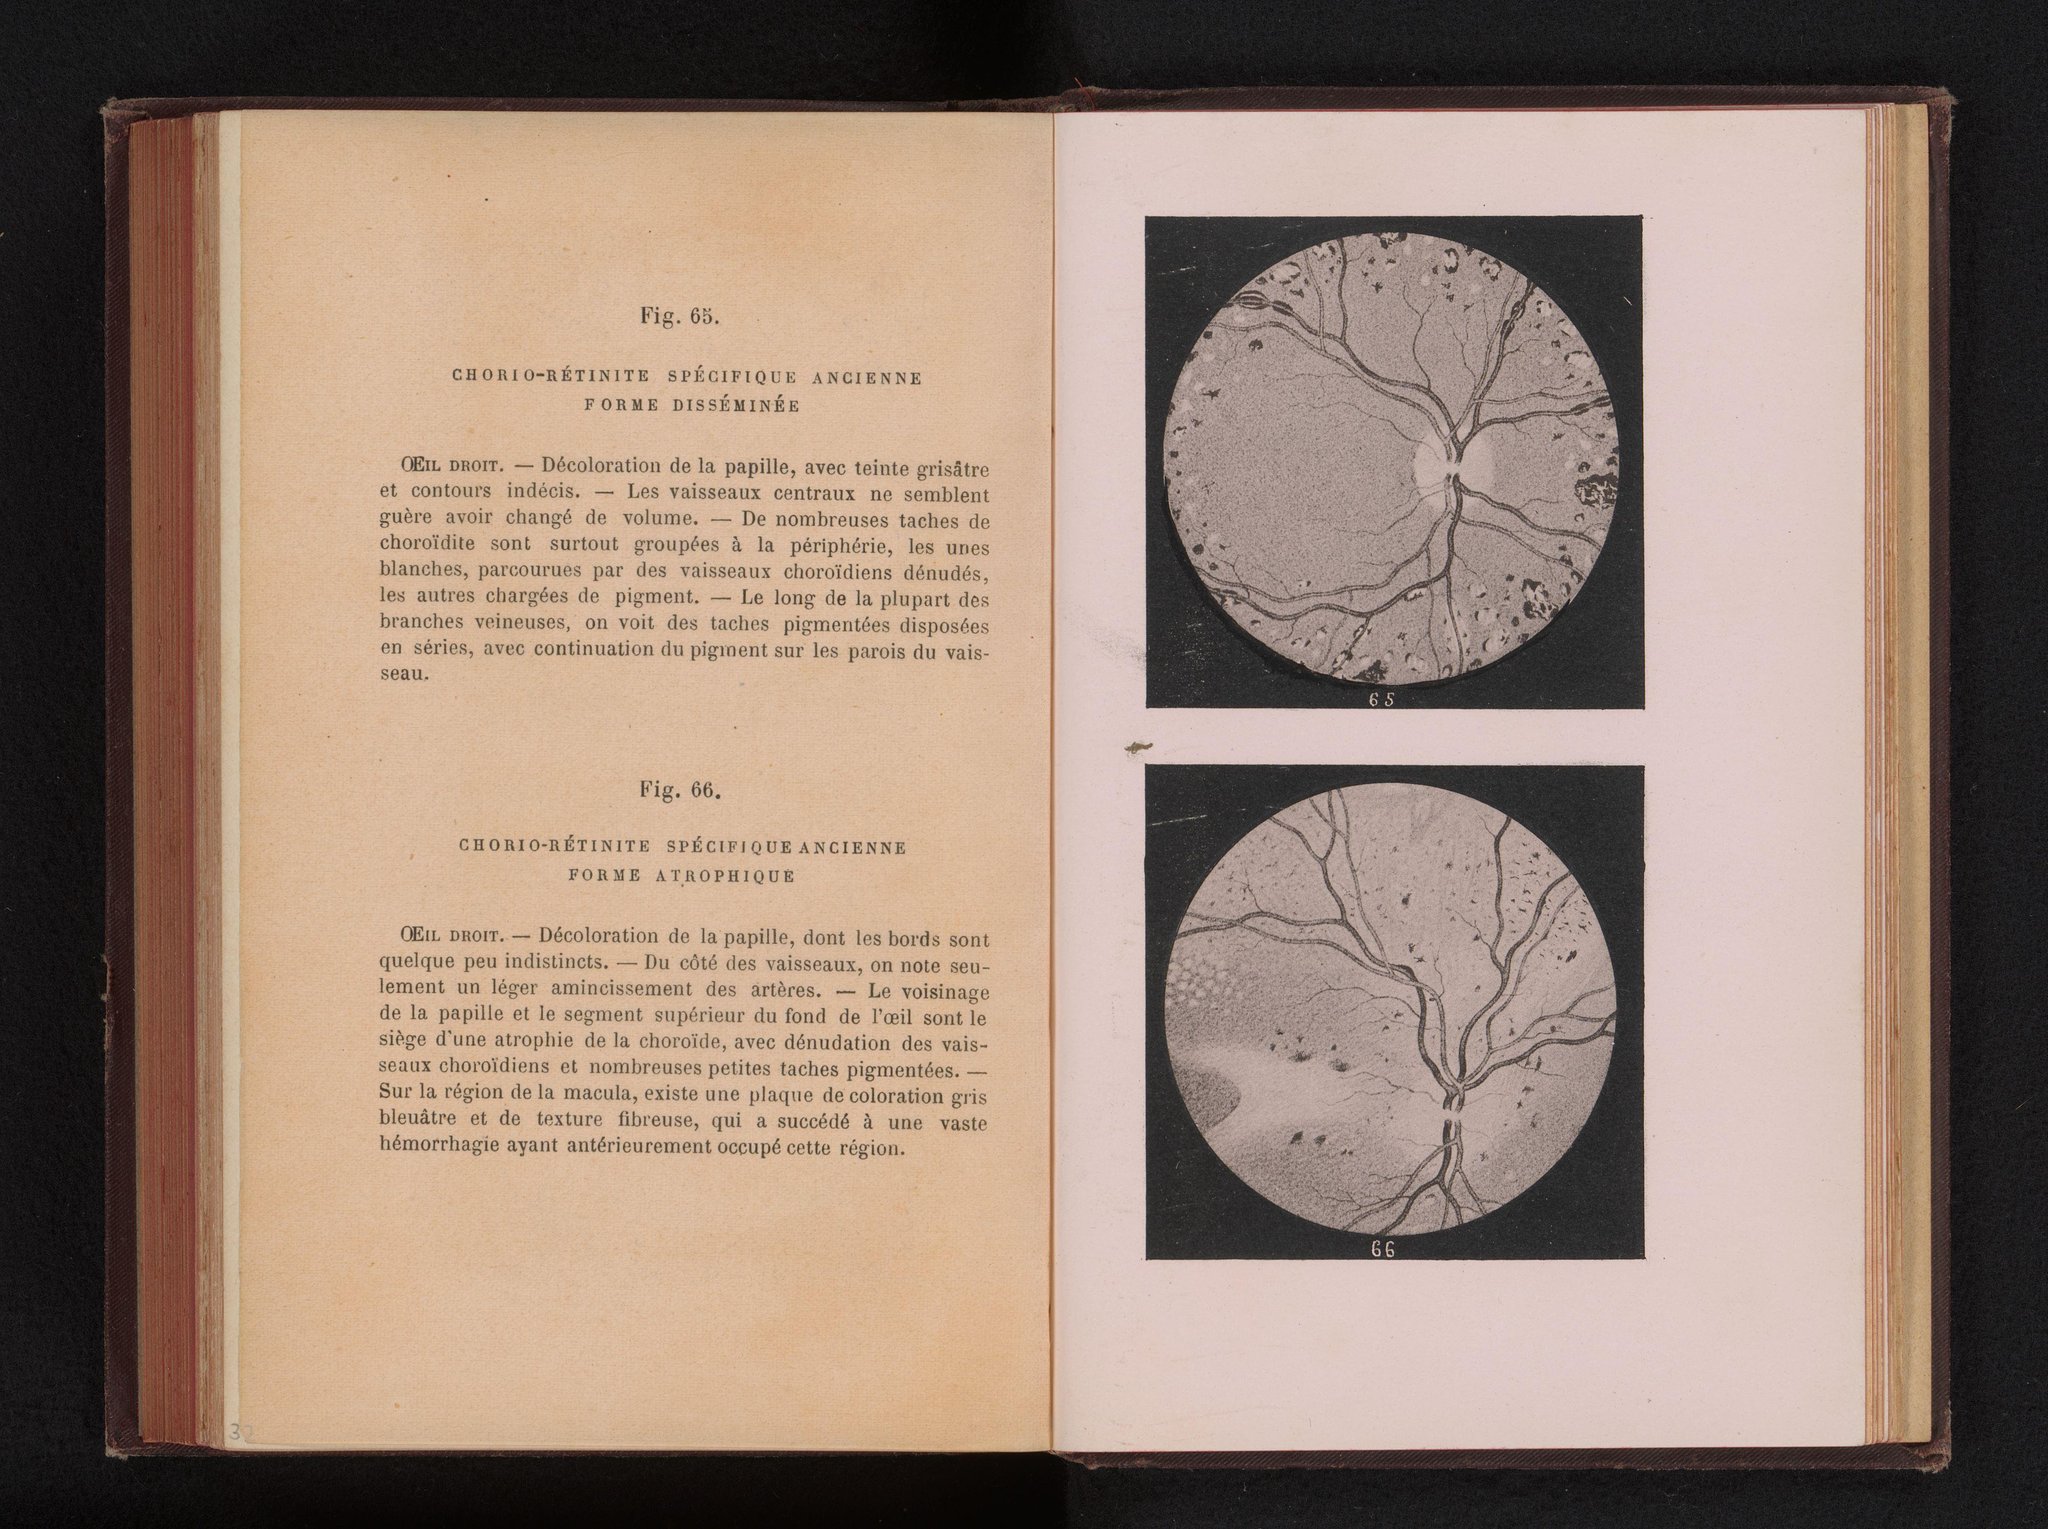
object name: reproduction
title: Fotoreproductie van twee anatomische tekeningen van een ontsteking aan het vaatvlies in een oog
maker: Anonymous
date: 1871-1891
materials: paper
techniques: photograph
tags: anatomy (non-medical), eyes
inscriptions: inscription: ‘Fig. 65. Chorio-rétinite spécifique ancienne forme disséminée Fig. 66. Chorio-rétinite spécifique ancienne forme antrophique’